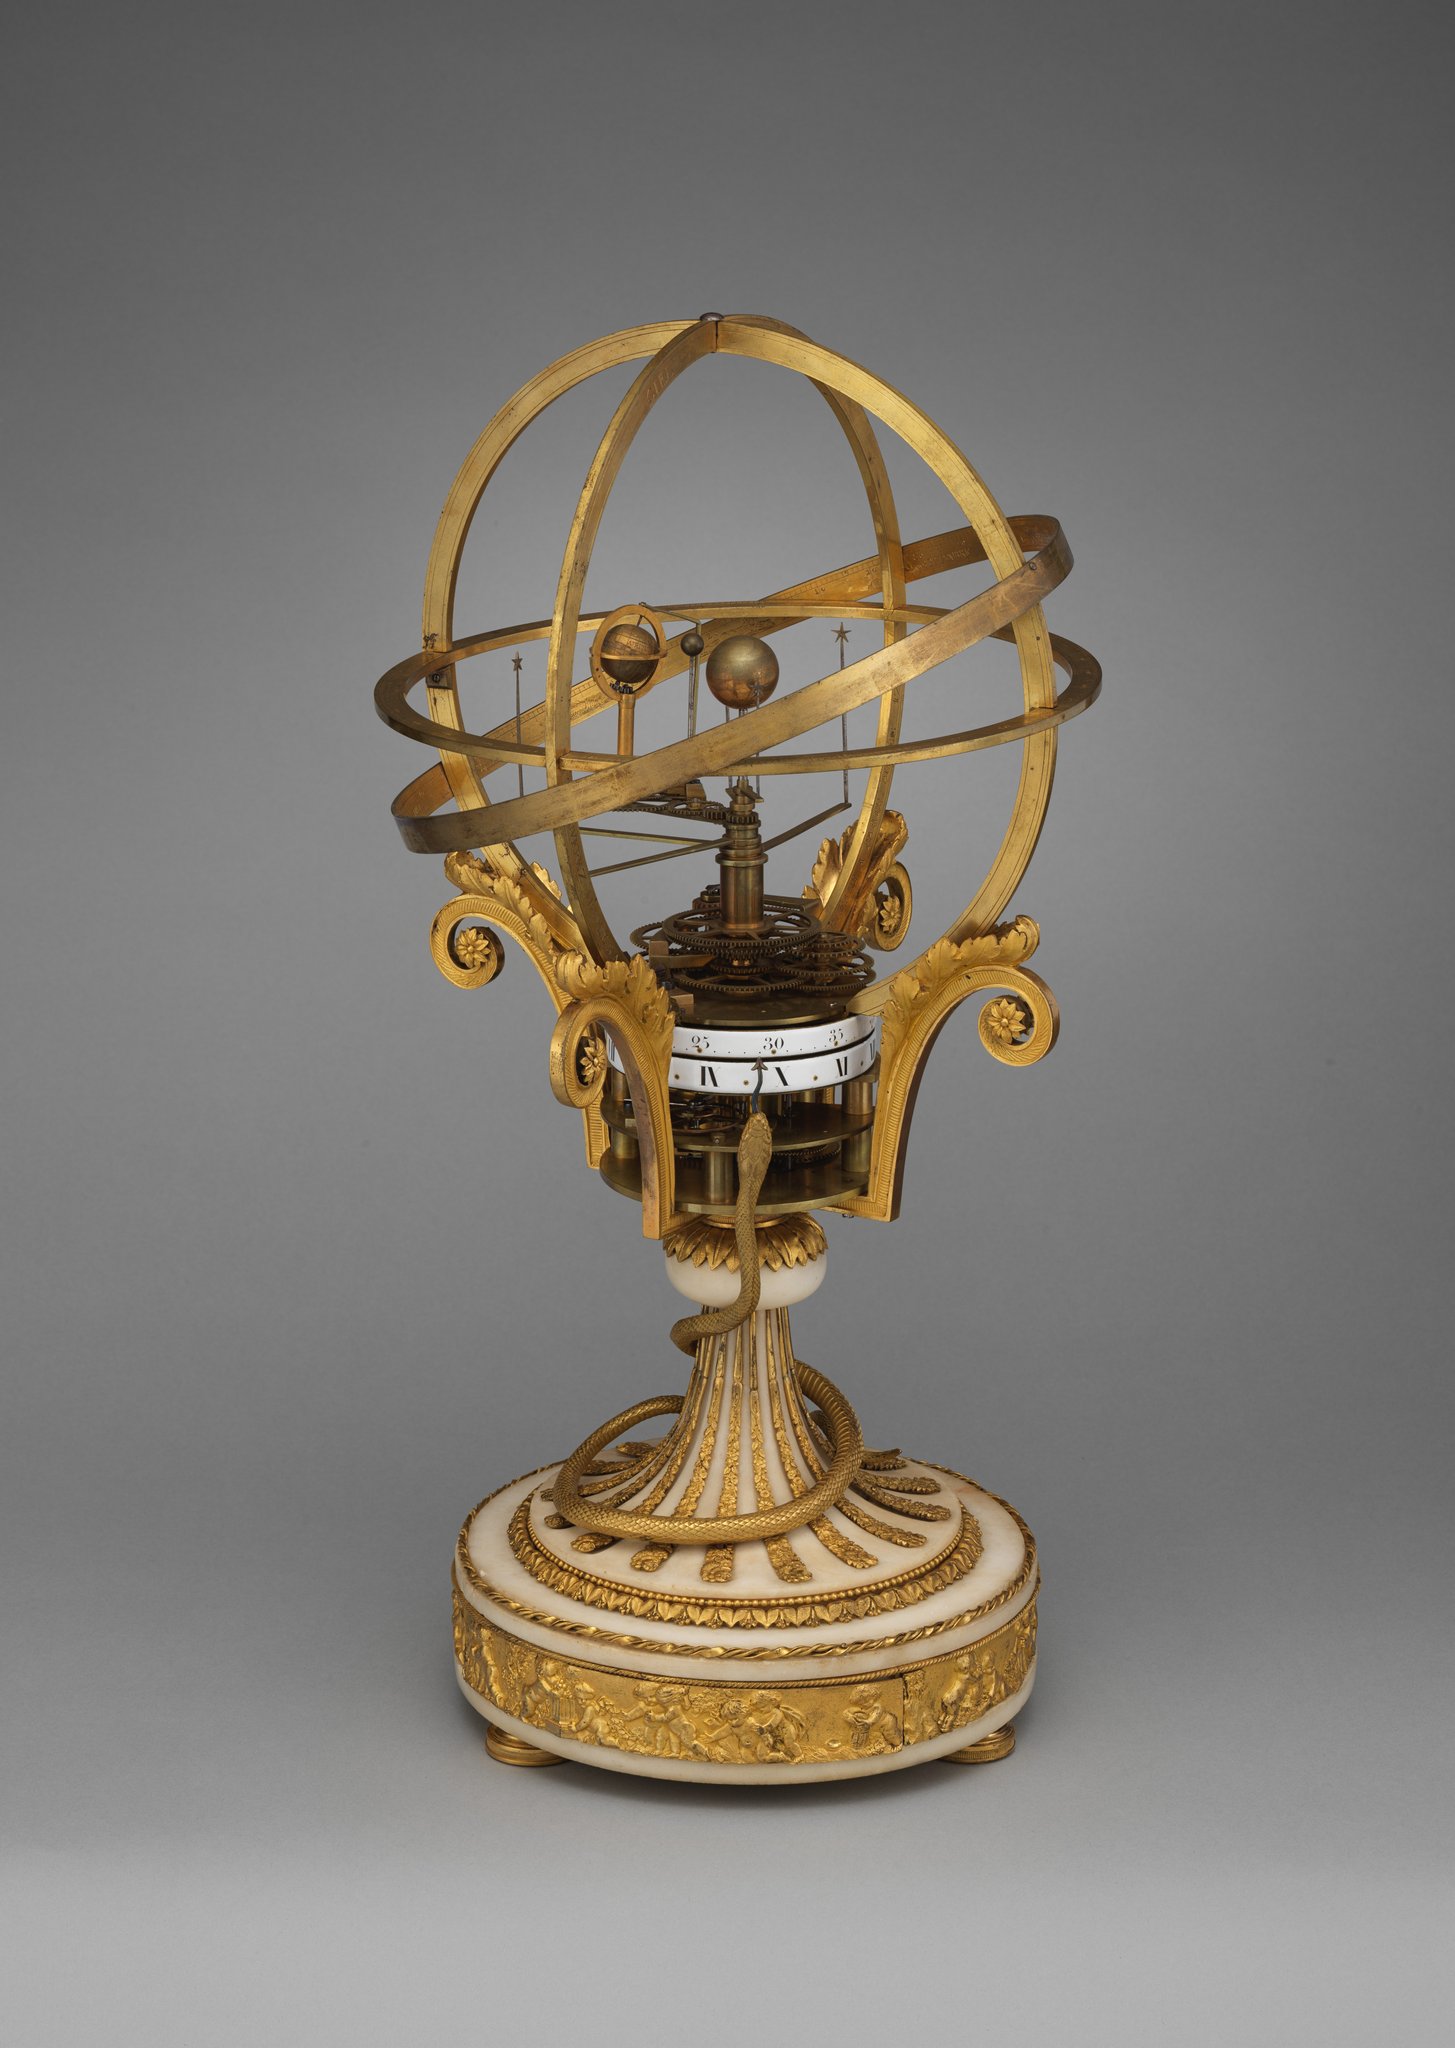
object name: orrery clock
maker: louis thouverez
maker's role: maker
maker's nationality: french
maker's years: 1788-1823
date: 1790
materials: brass, bronze, copper, enamel, marble, steel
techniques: casting, gilding